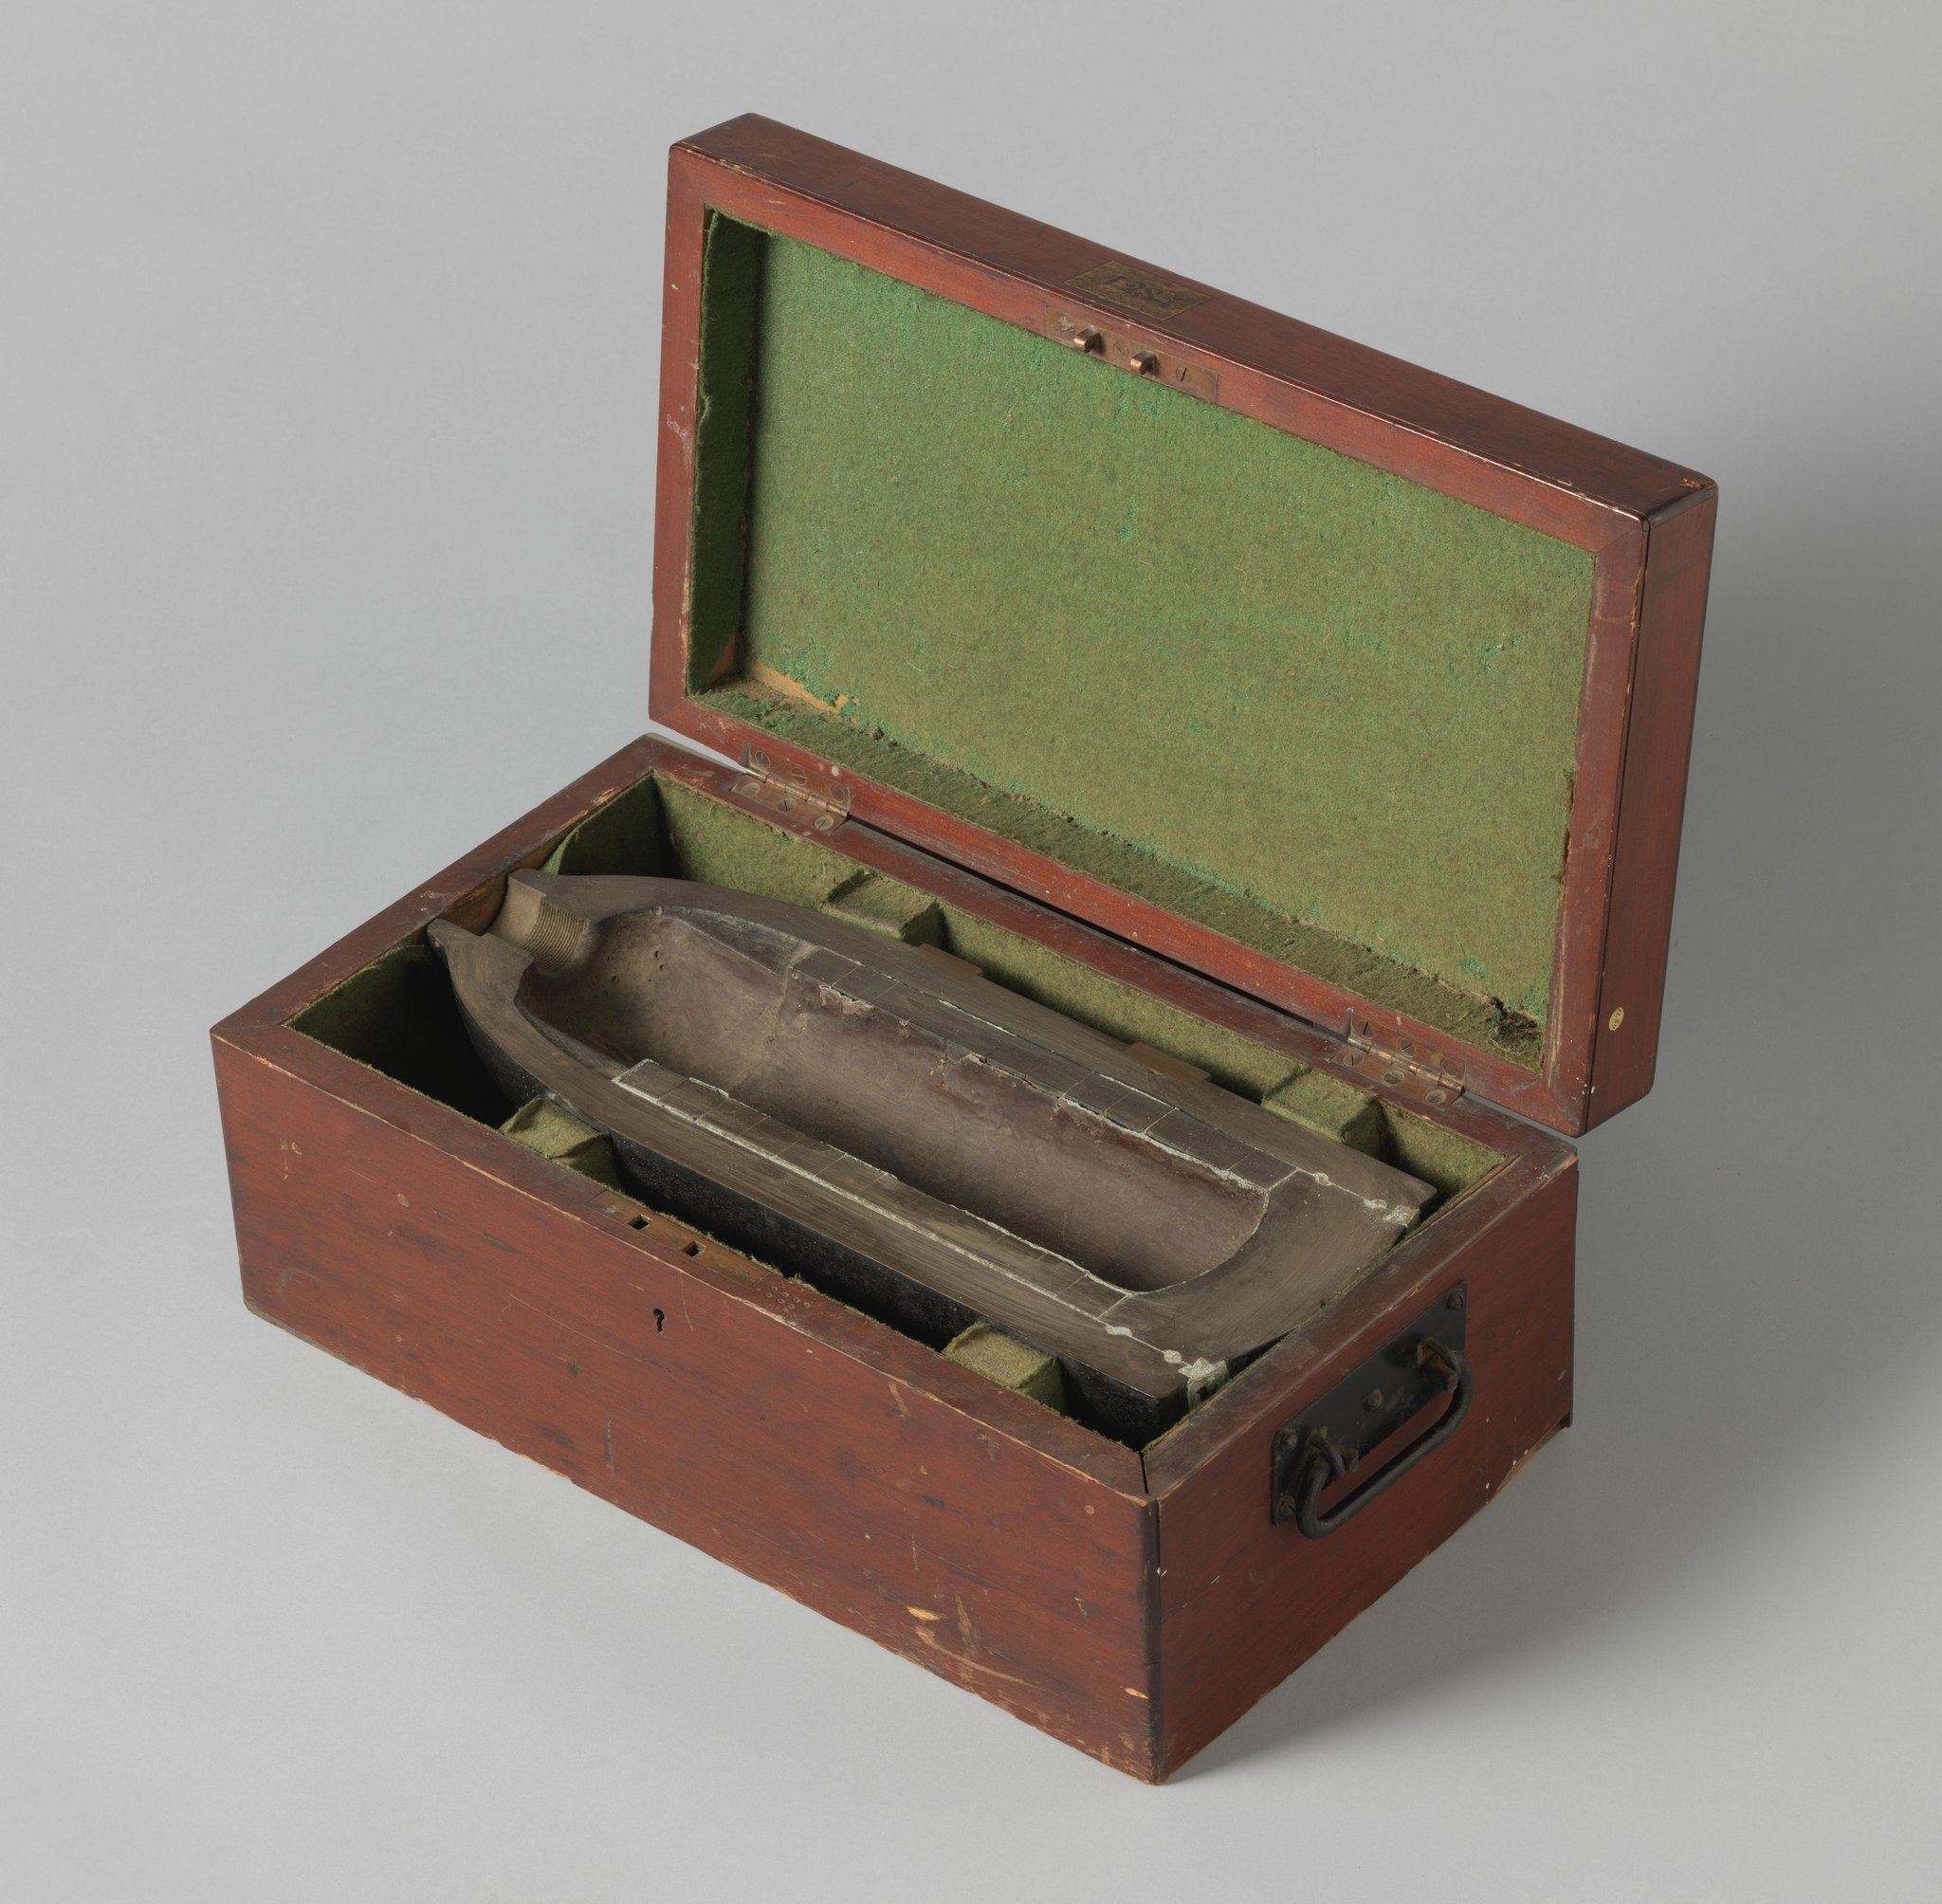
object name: chest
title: 18-cm Segment Shell in a Wooden Box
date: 1868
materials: brass, bronze, iron, lead, wood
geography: newcastle upon tyne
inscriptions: inscription, on the lock of the box: ‘John Shaw & Sons / Wolverhampton / Safety patent lever lock.’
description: Een halve overlangs doormidden gezaagde puntvormige 18 cm granaat, in een houten kist. De granaat is 45 cm lang en heeft een kaliber van 176 mm. Hij heeft twee ringen bronzen nokken voor een getrokken loop met drie trekkende velden. De neus heeft de vorm van een flessehals met een buisgat. De granaat is hol: de springlading is omgeven door twaalf ijzeren segmentringen, die met lood aaneengekit zijn. De ingezette bodem is tevens met loden ringen vastgemaakt.